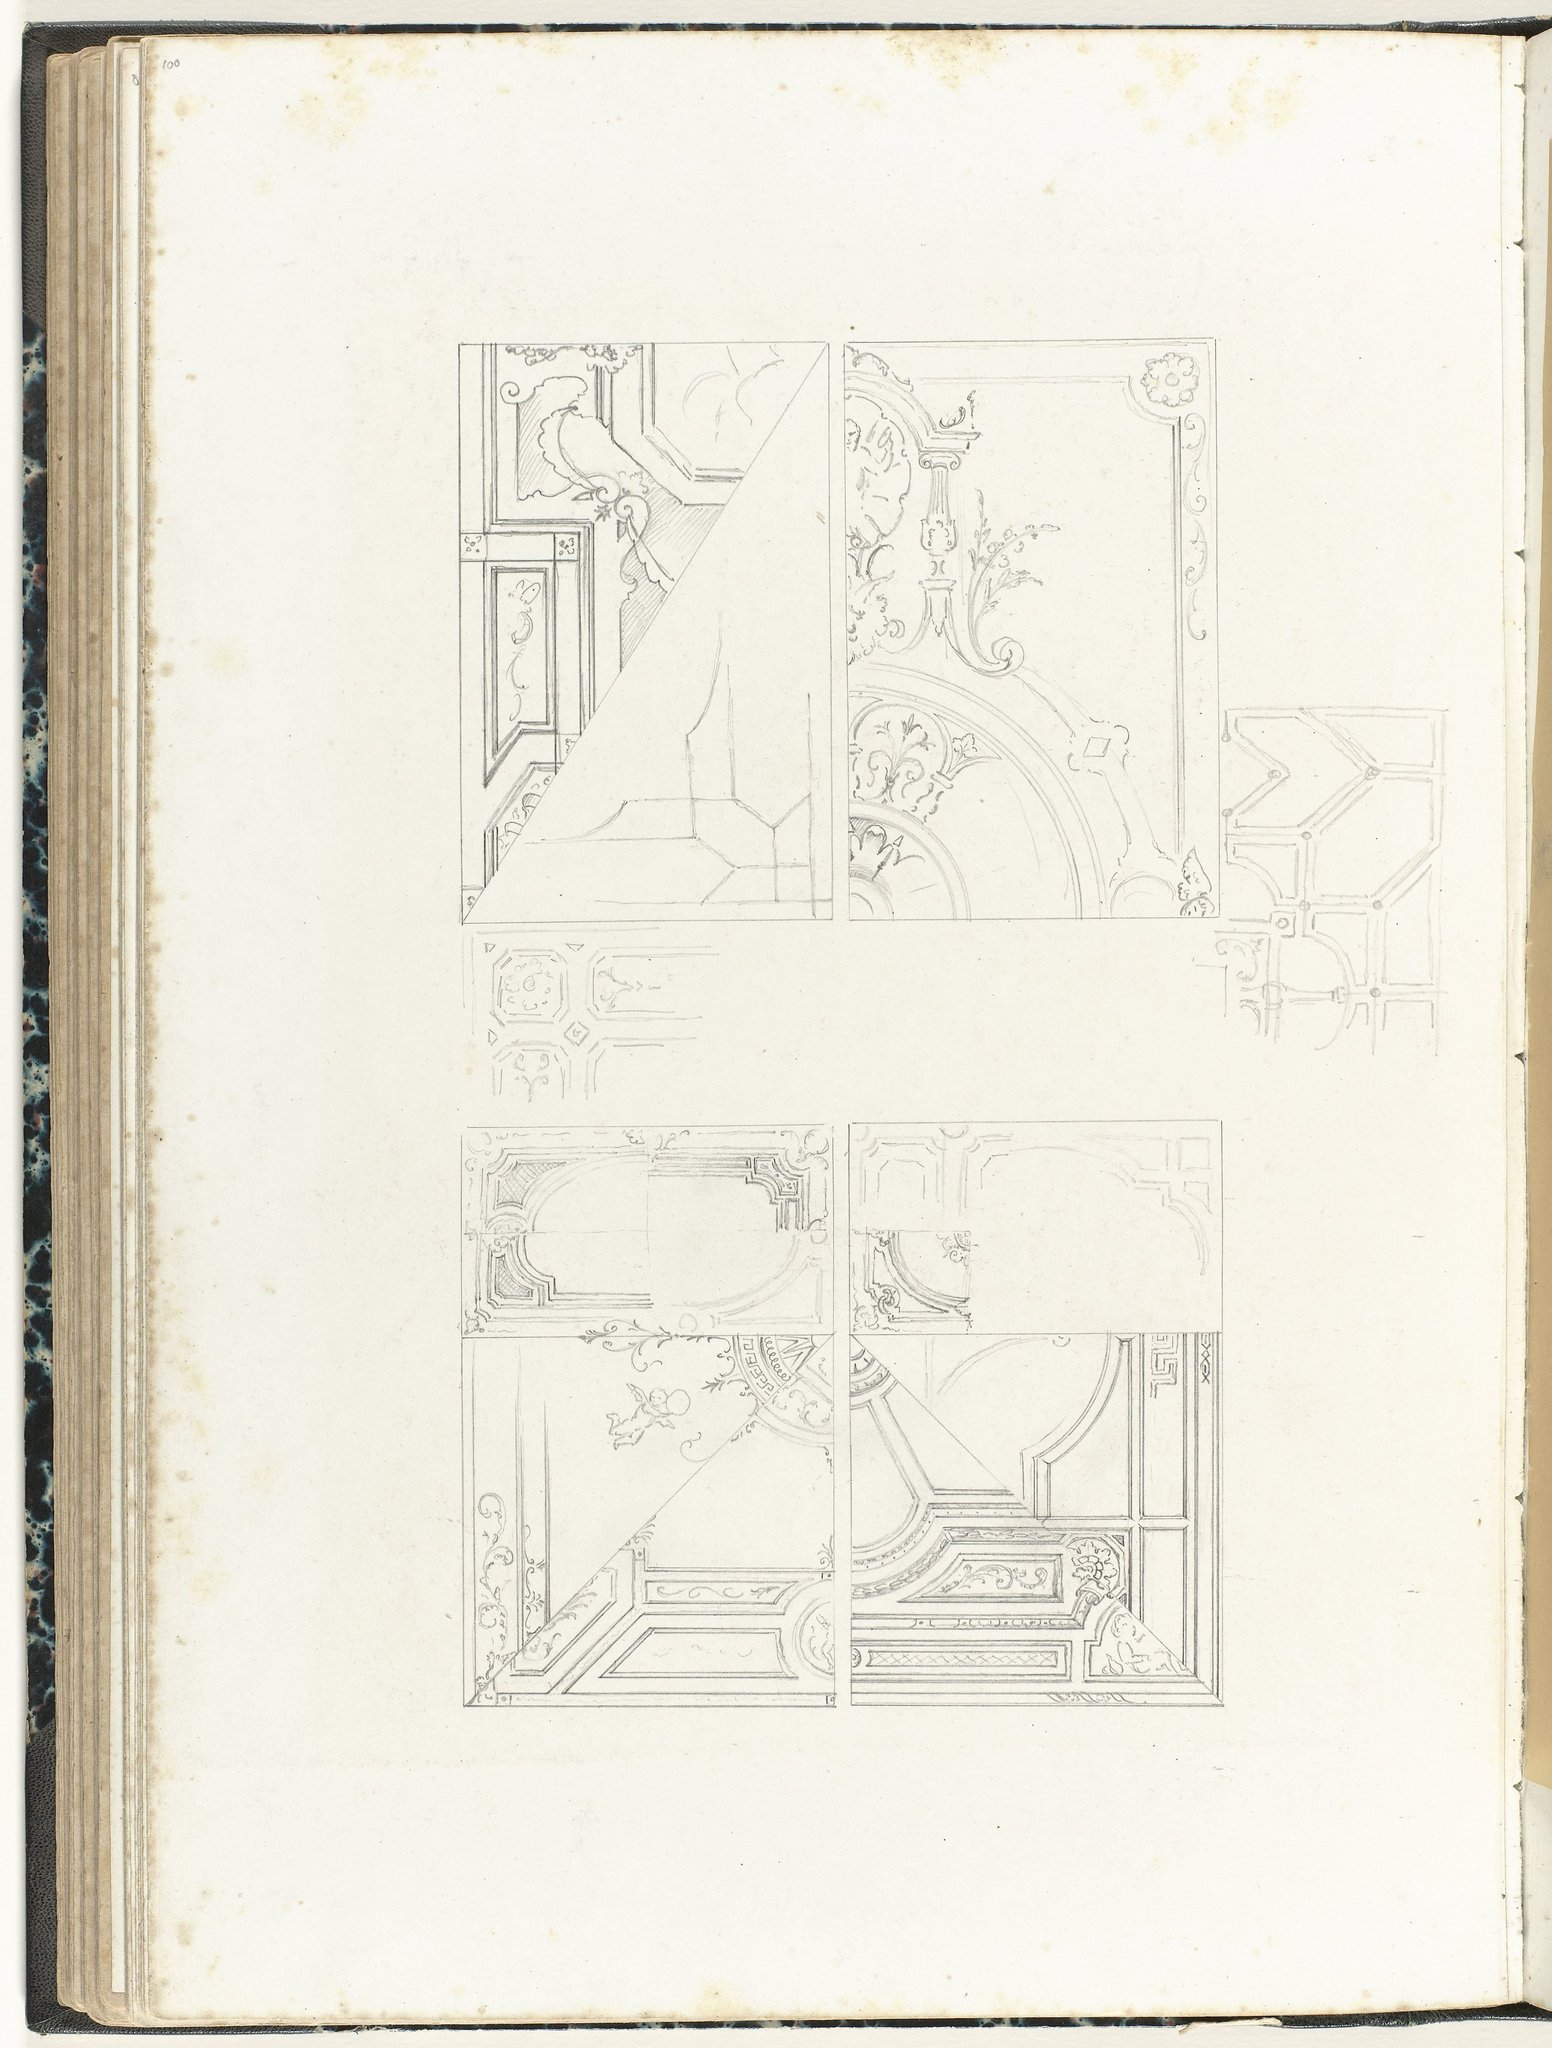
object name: drawing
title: Delen van plafonds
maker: Anonymous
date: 1866-1900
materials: paper, pencil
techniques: drawing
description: In vier kaders zijn delen van plafonds getekend, daarbuiten staan nog twee schetsen.